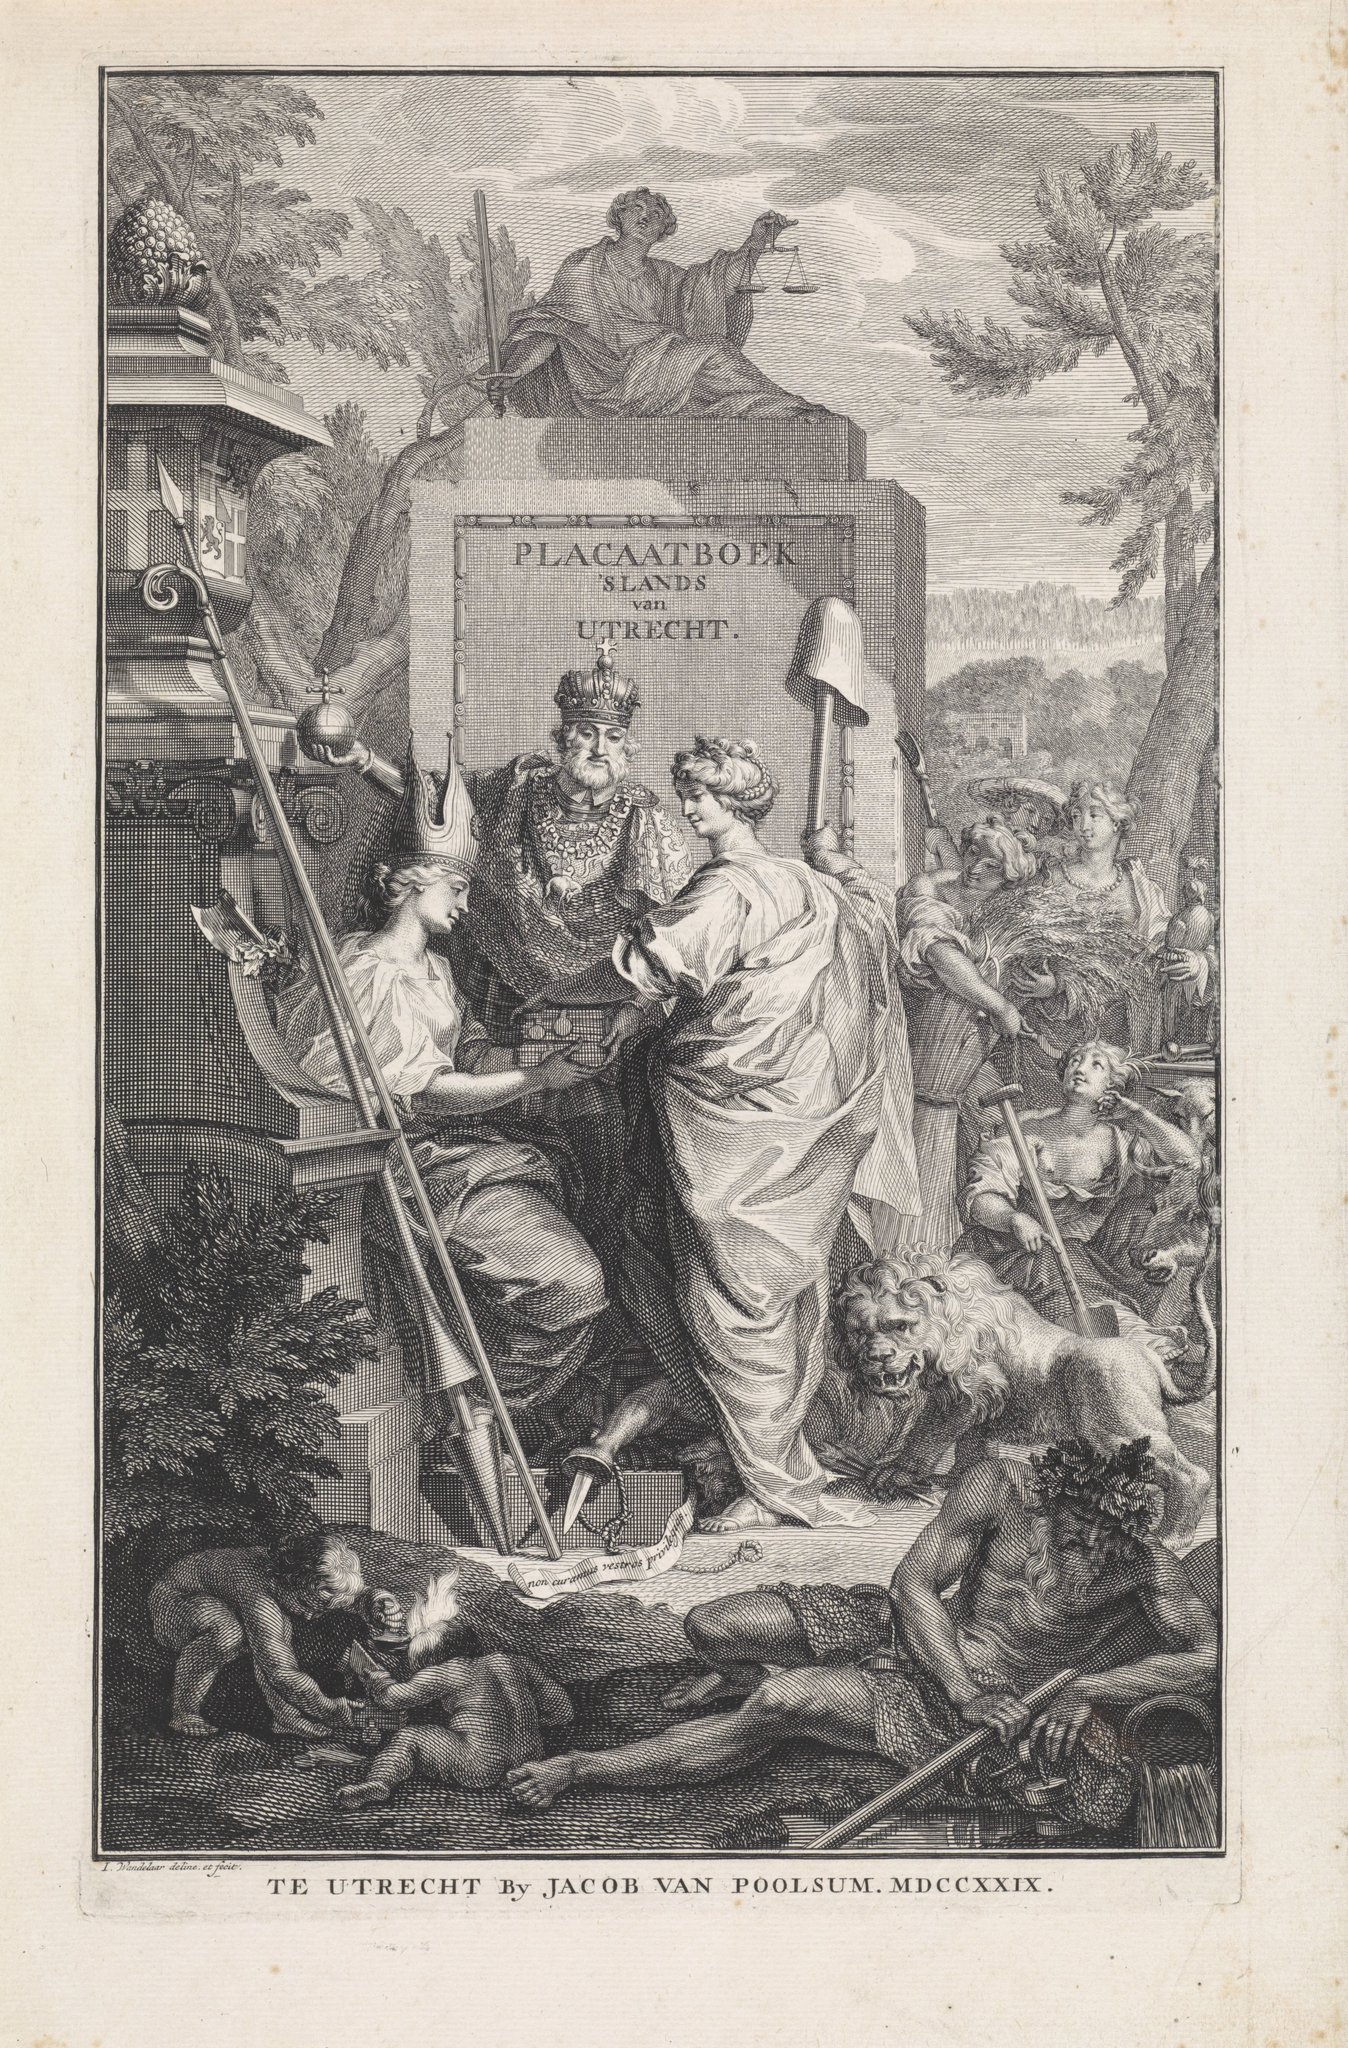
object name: titelblad, titelpagina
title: Allegorische voorstelling met de stichting van Utrecht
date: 1729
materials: paper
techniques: engraving, etching, letterpress printing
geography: utrecht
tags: ghent, charles v (holy roman emperor and king of spain), justice, 'justitia'; 'giustitia divina' (ripa) ~ one of the four cardinal virtues, personifications of countries, nations, states, districts, etc., knighthood order of the golden fleece, river personified: rhine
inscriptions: collector's mark: Lugt 240, number: ‘No. 565 .. io:’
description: De Hollandse Maagd, met een leeuw aan haar voeten, en keizer Karel V, met zijn keizersattributen, overhandigen de personificatie van Utrecht een stapel plakkaten. Achter hen een monument waarop de titel in het Nederlands, bekroond met Rechtvaardigheid. Op de voorgrond de riviergod van de Rijn en twee putti bij een boek. Rechts op de achtergrond vier allegorische vrouwfiguren die de land- en akkerbouw, het vee hoeden en de jacht symboliseren. Op de andere zijde een "Verklaring der Tytelprint" in boekdruk in het Nederlands.